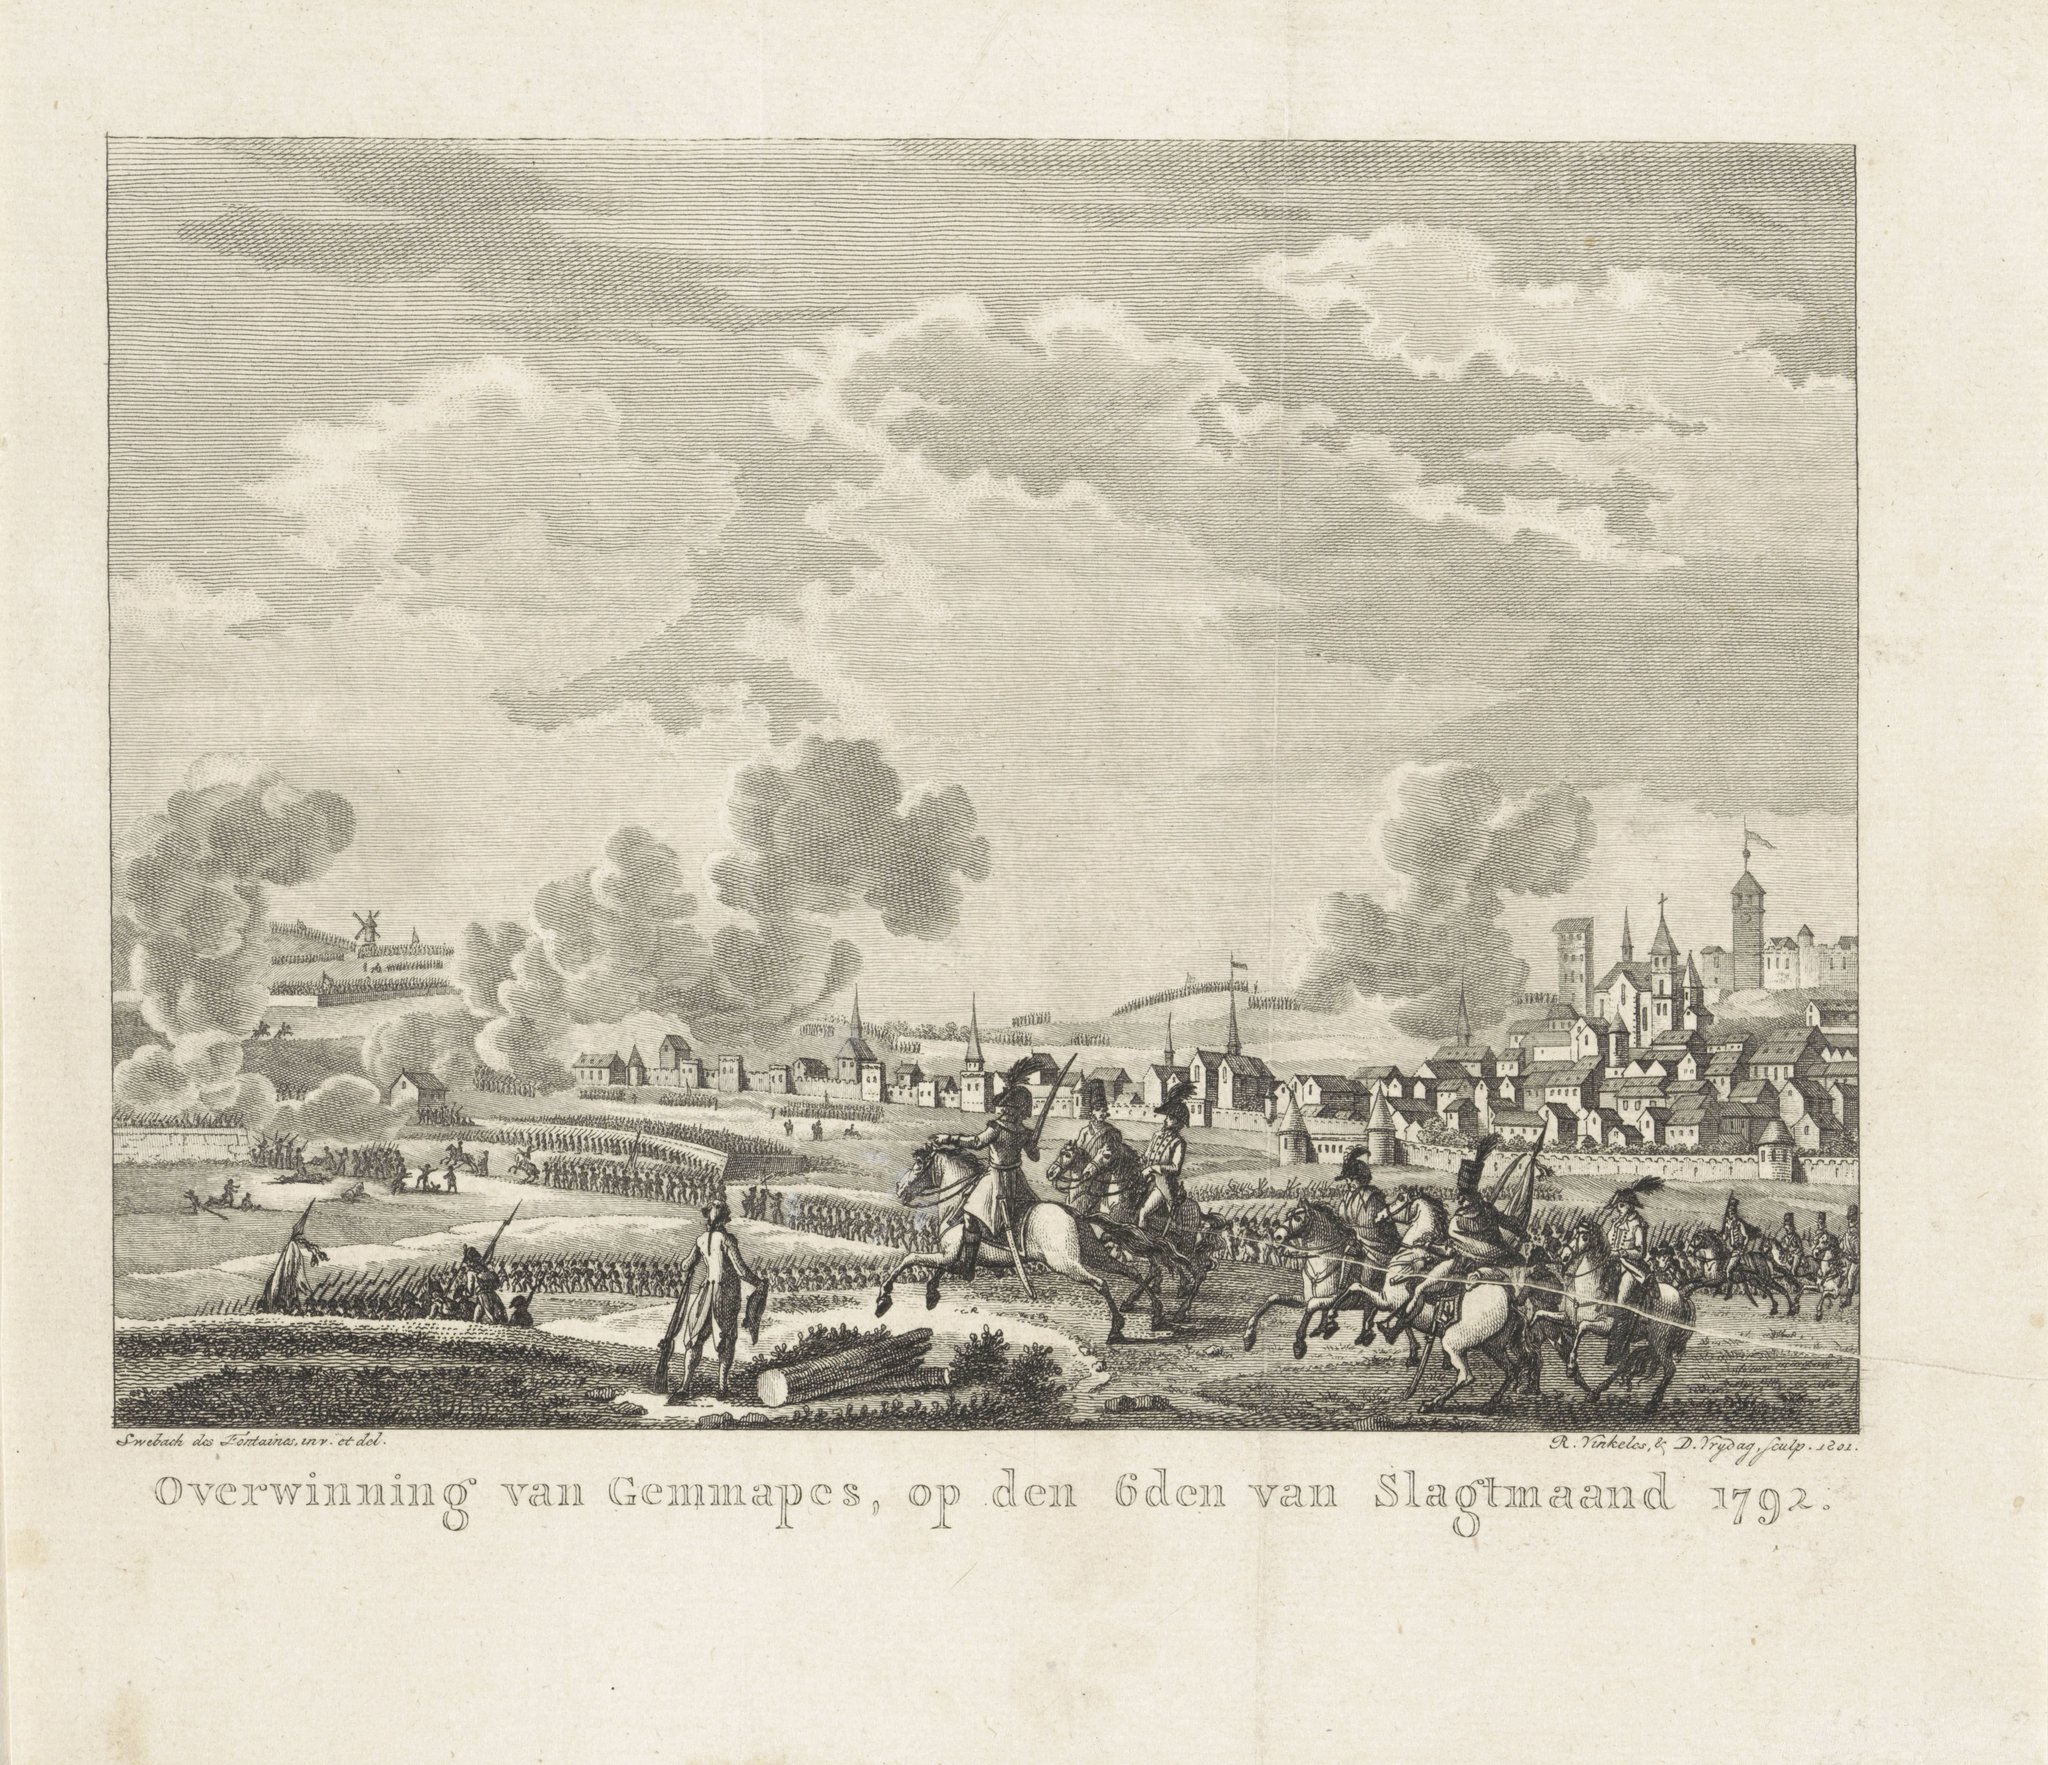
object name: print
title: Slag bij Jemappes, 1792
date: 1801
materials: paper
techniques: engraving, etching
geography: northern netherlands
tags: battle (+ land forces)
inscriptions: collector's mark: Lugt 2228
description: Slag bij Jemappes in Henegouwen met een overwinning van de Franse revolutionaire troepen onder generaal Charles-François Dumouriez op het Oostenrijkse leger, 6 november 1792.